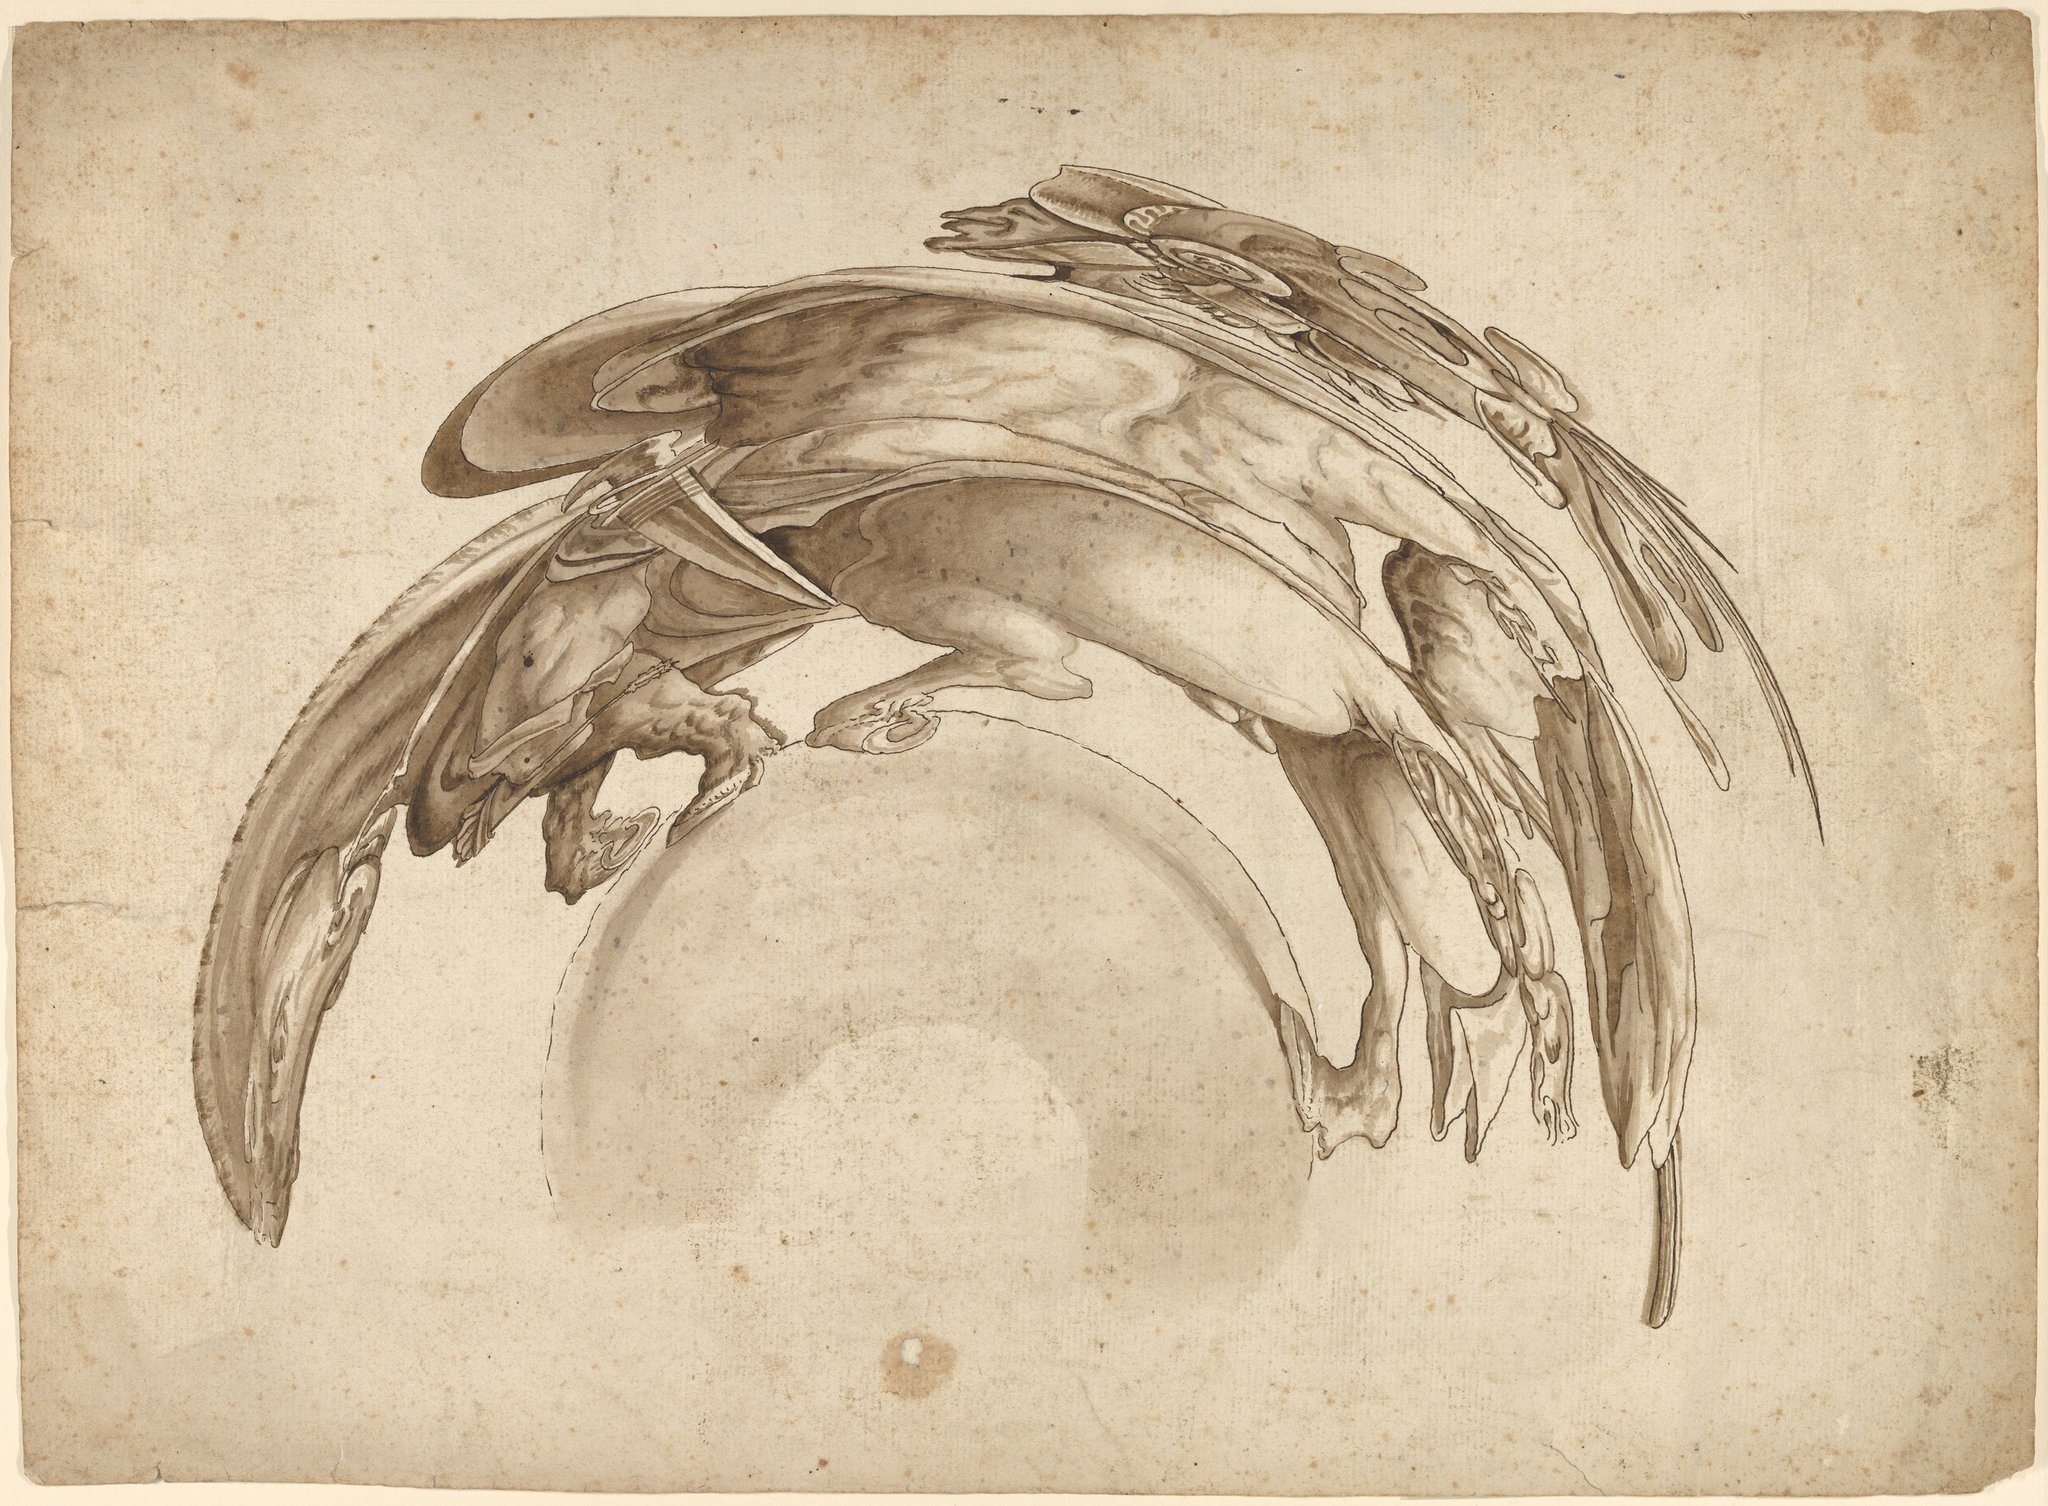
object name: drawing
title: Soldier on Horseback in Catoptric Anamorphosis (after Hendrick Goltzius)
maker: jean françois niceron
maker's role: artist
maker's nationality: french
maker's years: 1613-1646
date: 1620-1640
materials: chalk, ink, drawing material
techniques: brush, pen, wash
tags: soldiers,horses